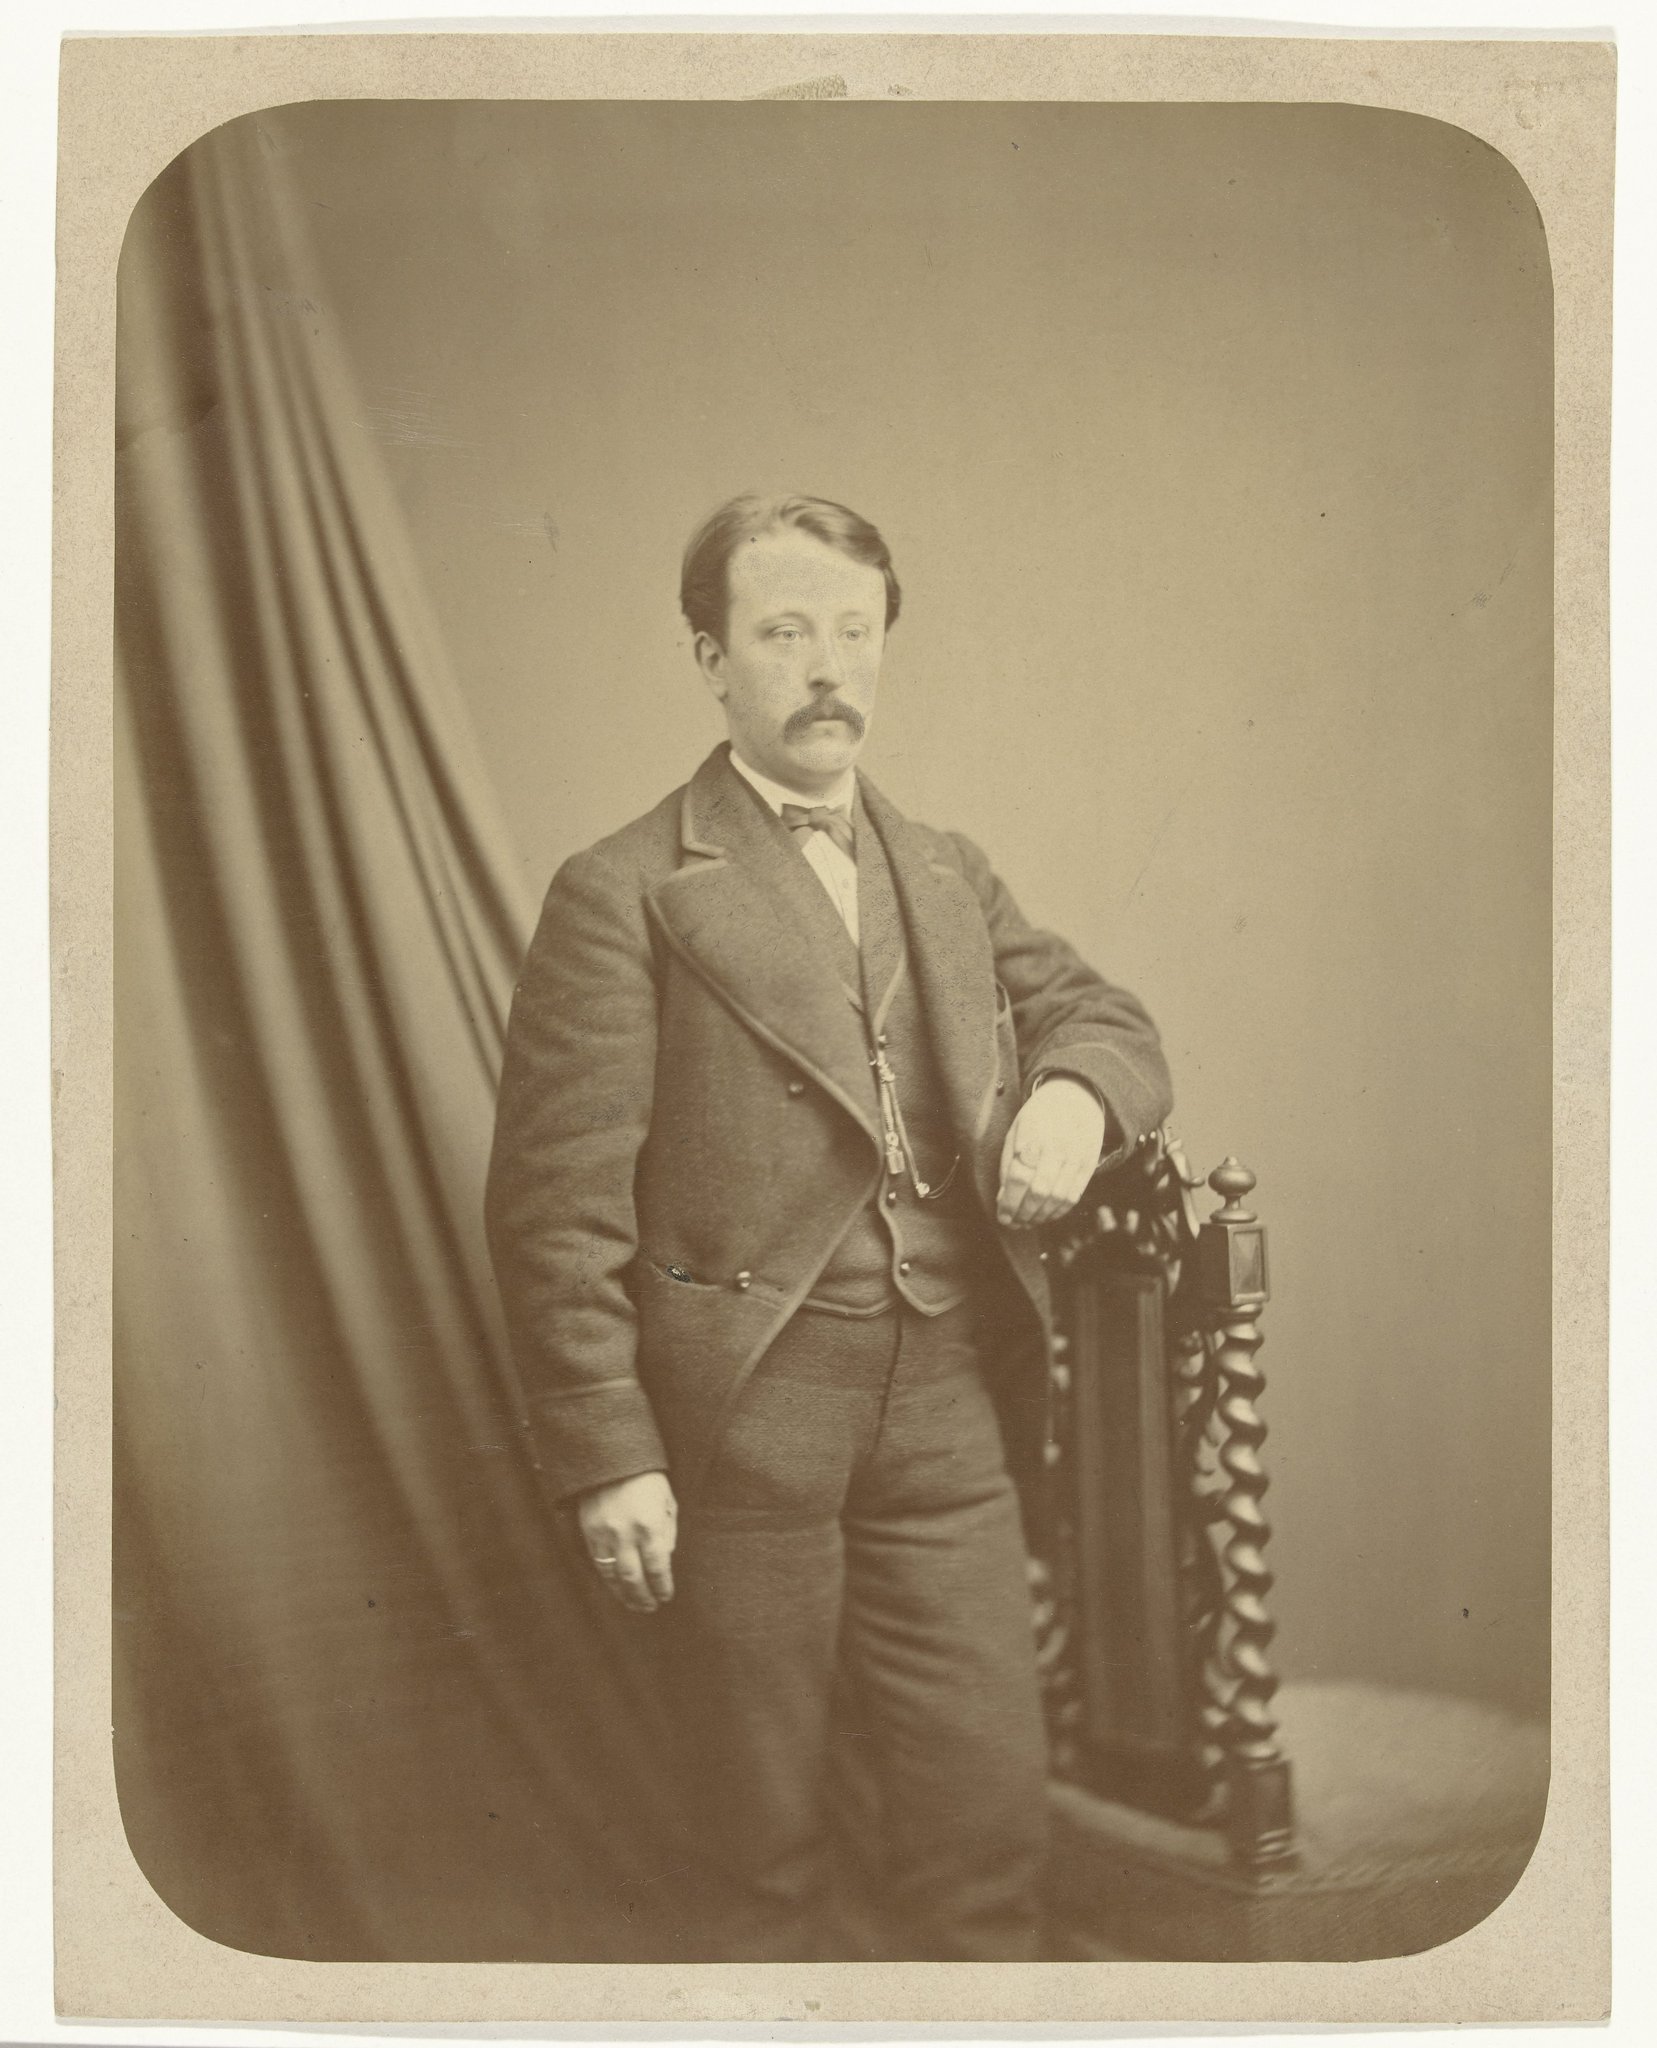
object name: photograph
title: Studioportret van een man in zwart pak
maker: Anonymous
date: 1870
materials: paper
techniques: albumen print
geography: netherlands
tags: historical persons not known by name